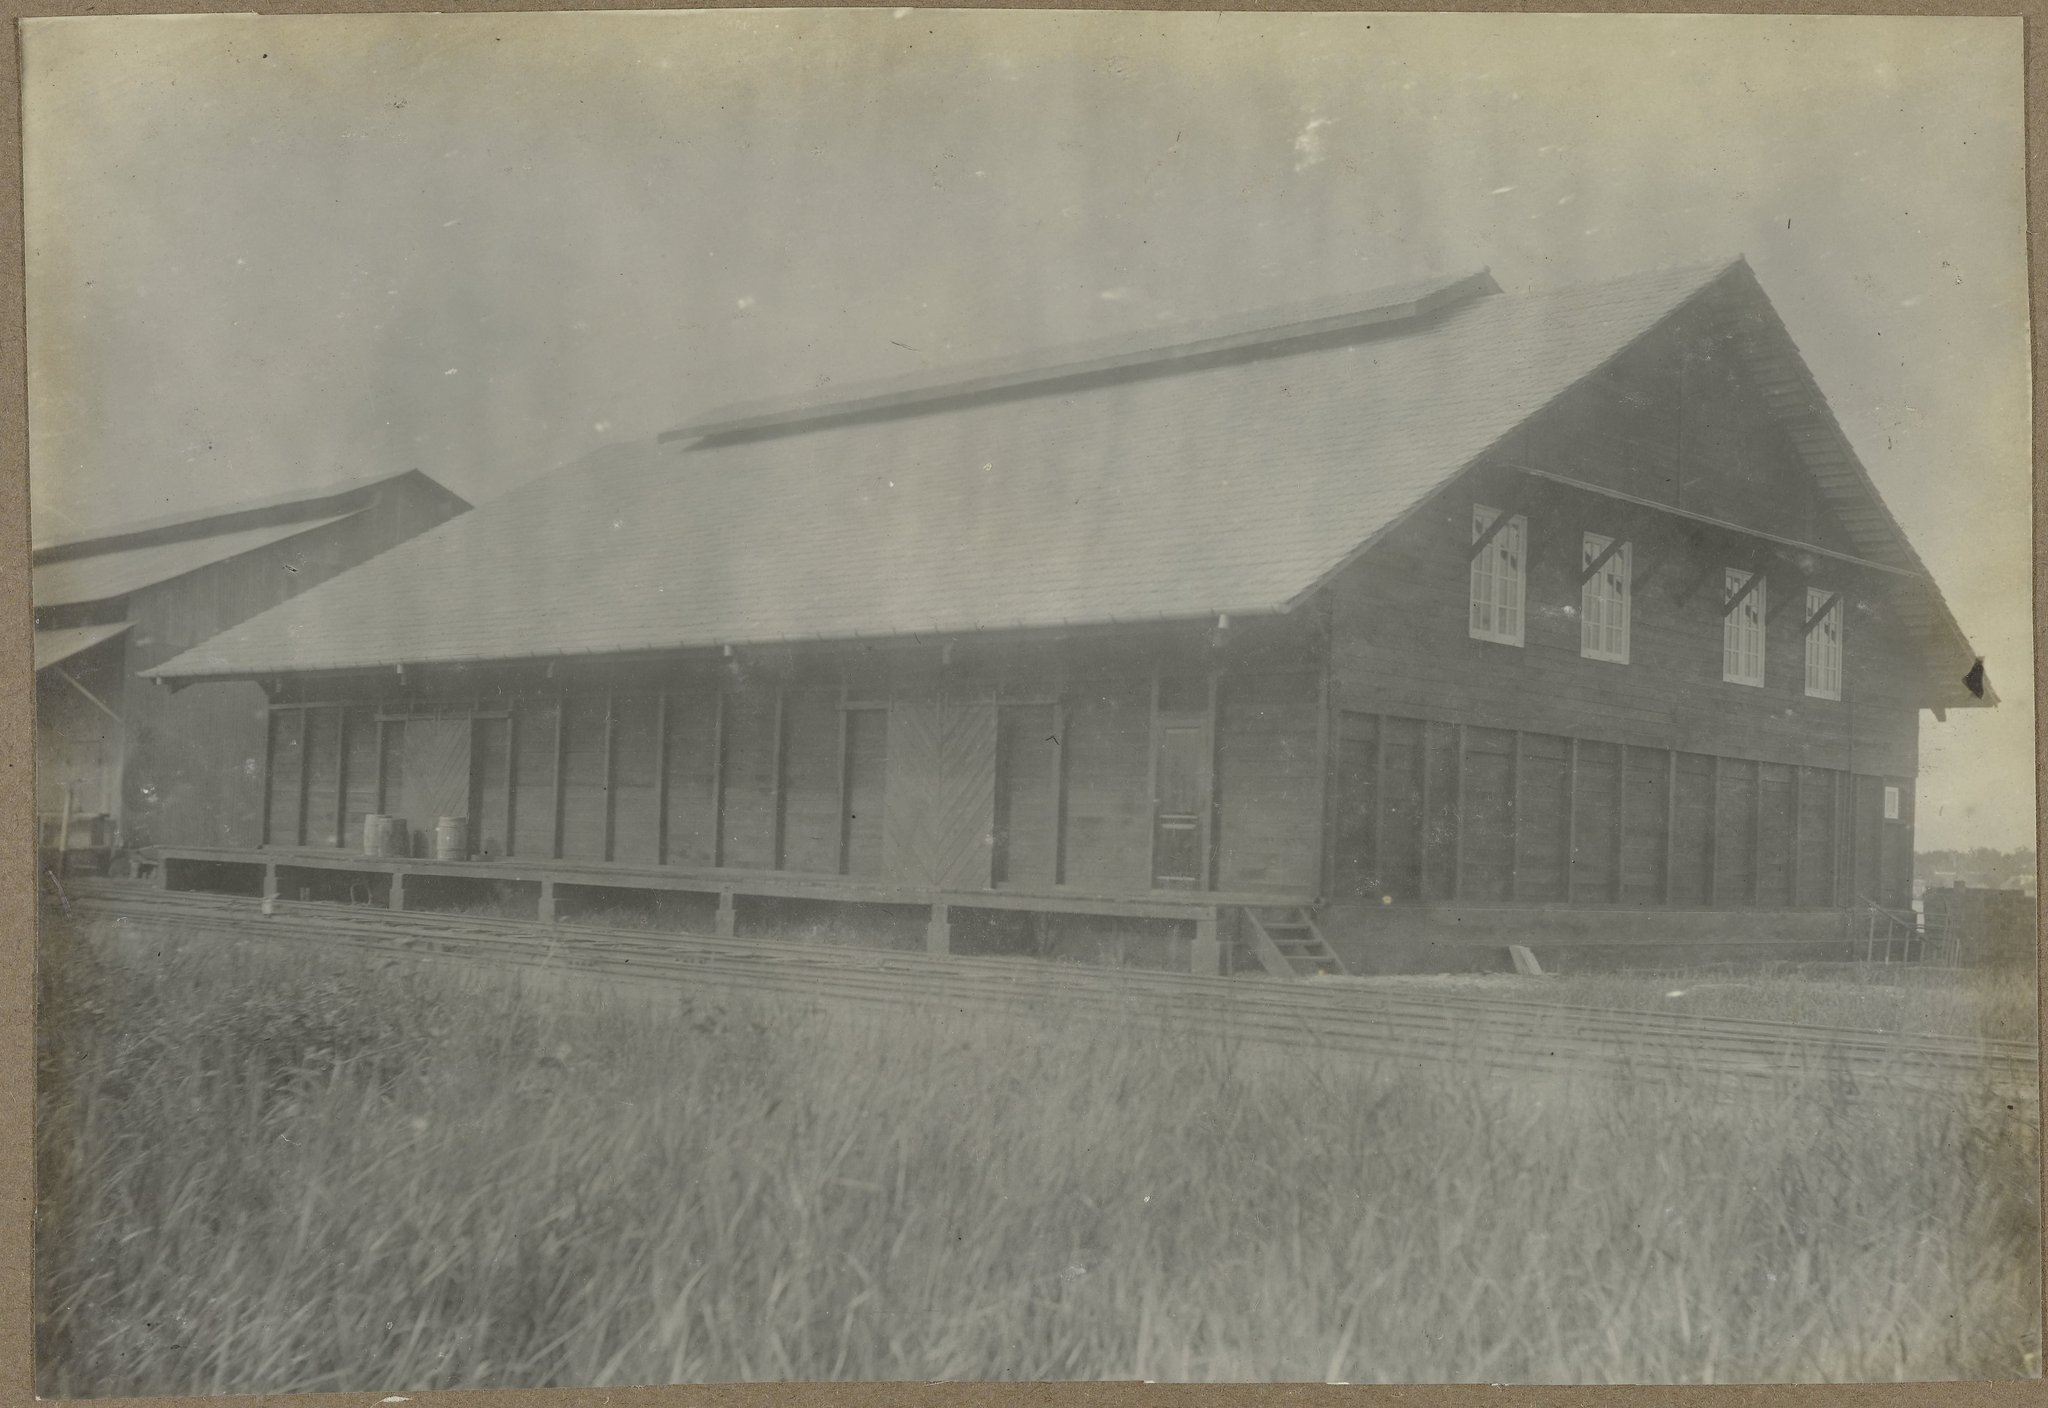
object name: photograph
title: Houten bedrijfspand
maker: Anonymous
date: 1914-1919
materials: photographic support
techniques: gelatin silver print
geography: medan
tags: large-scale structure for storage, e.g.: warehouse, depot, silo, representation of real building (either existing or having existed), architecture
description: Een nieuw houten bedrijfspand gelegen aan het spoor, waarschijnlijk te Medan. Foto in het fotoalbum van het Nederlandse architectenbureau en aannemersbedrijf Bennink en Riphagen te Medan in de jaren ca. 1914-1919.